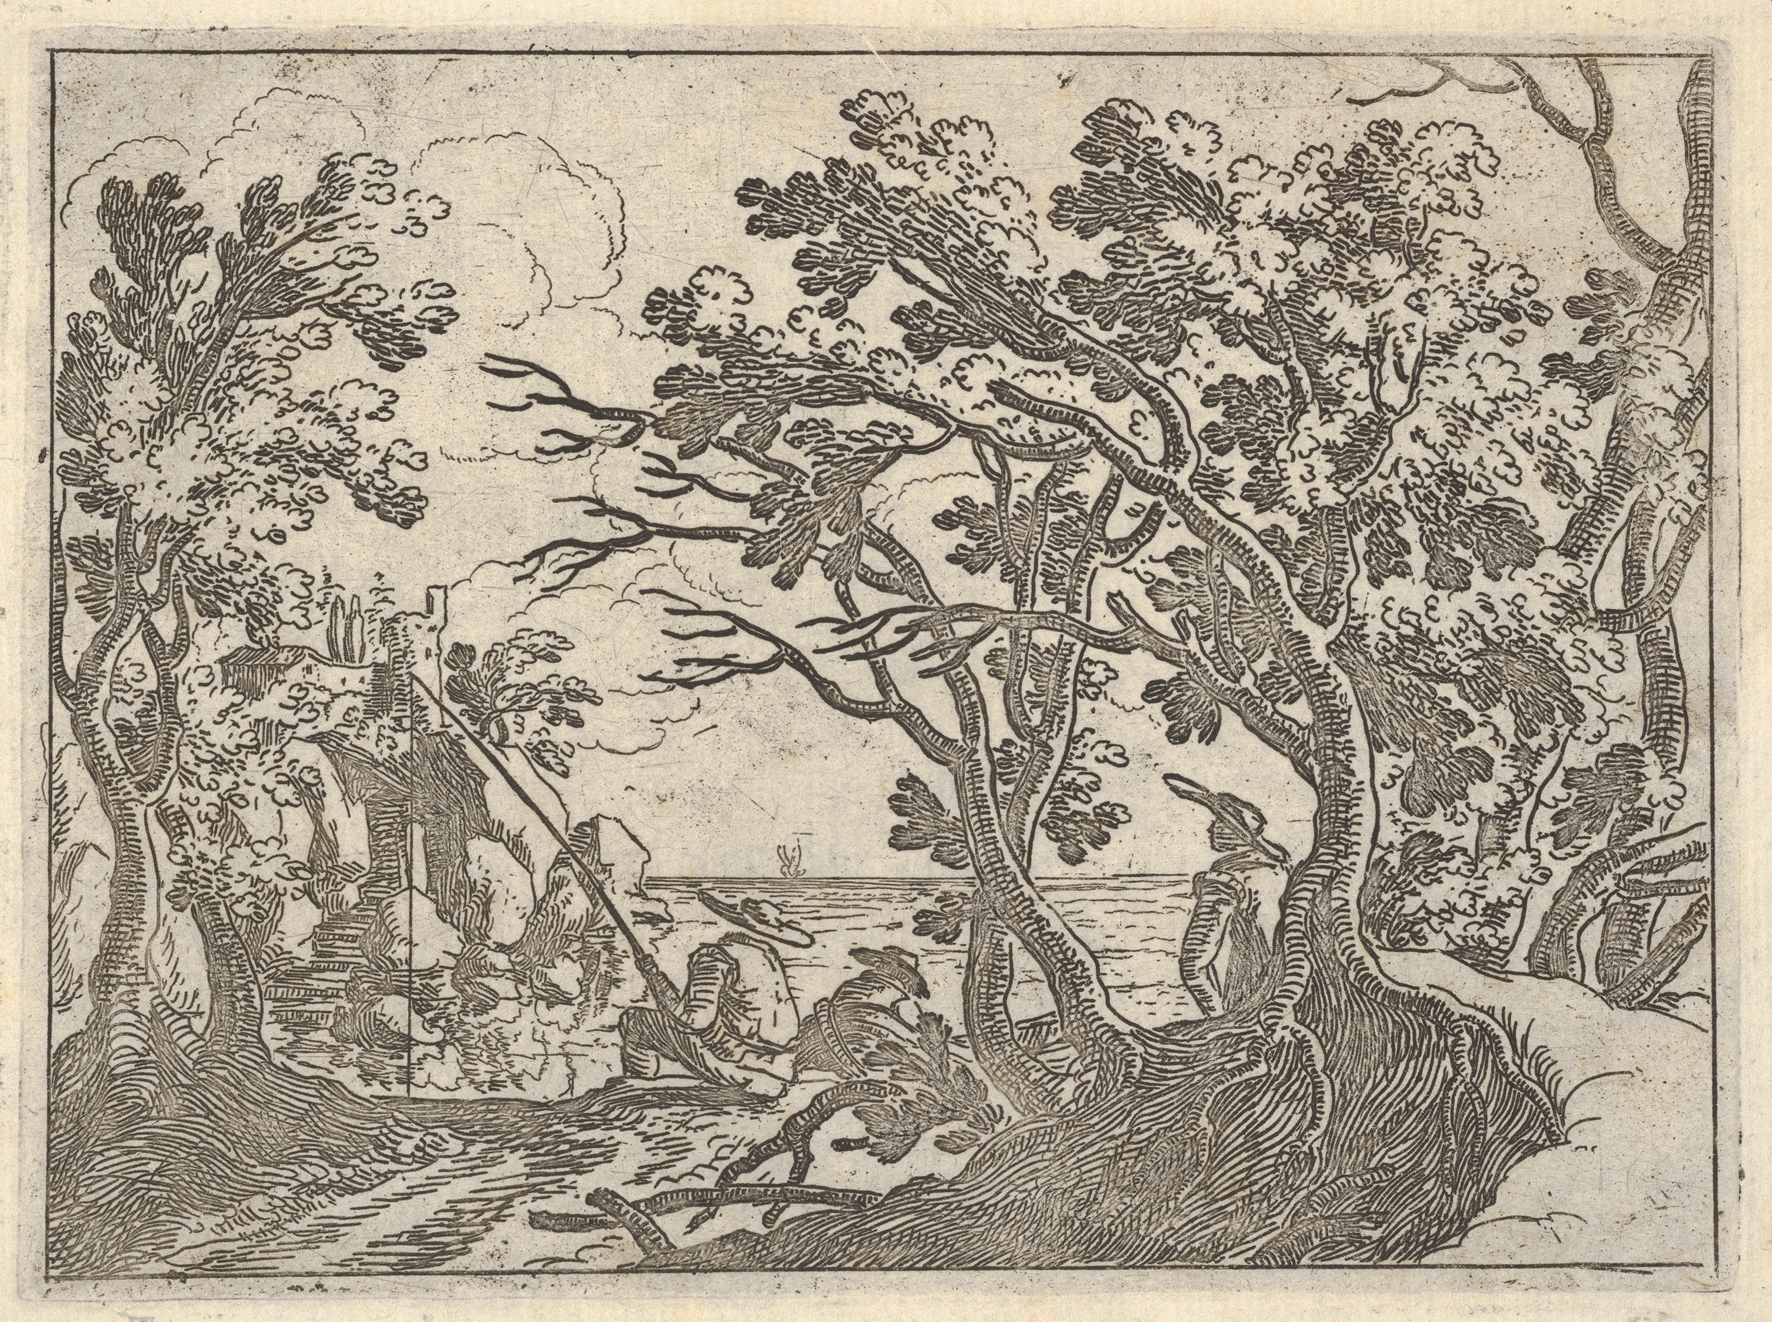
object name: print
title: Landscape with onshore fisherman and male onlooker under trees, a man in a boat bows his head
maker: remigio cantagallina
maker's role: artist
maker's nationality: italian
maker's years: 1582-1656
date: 1620-1650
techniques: etching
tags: men,fishing,landscapes,trees,boats